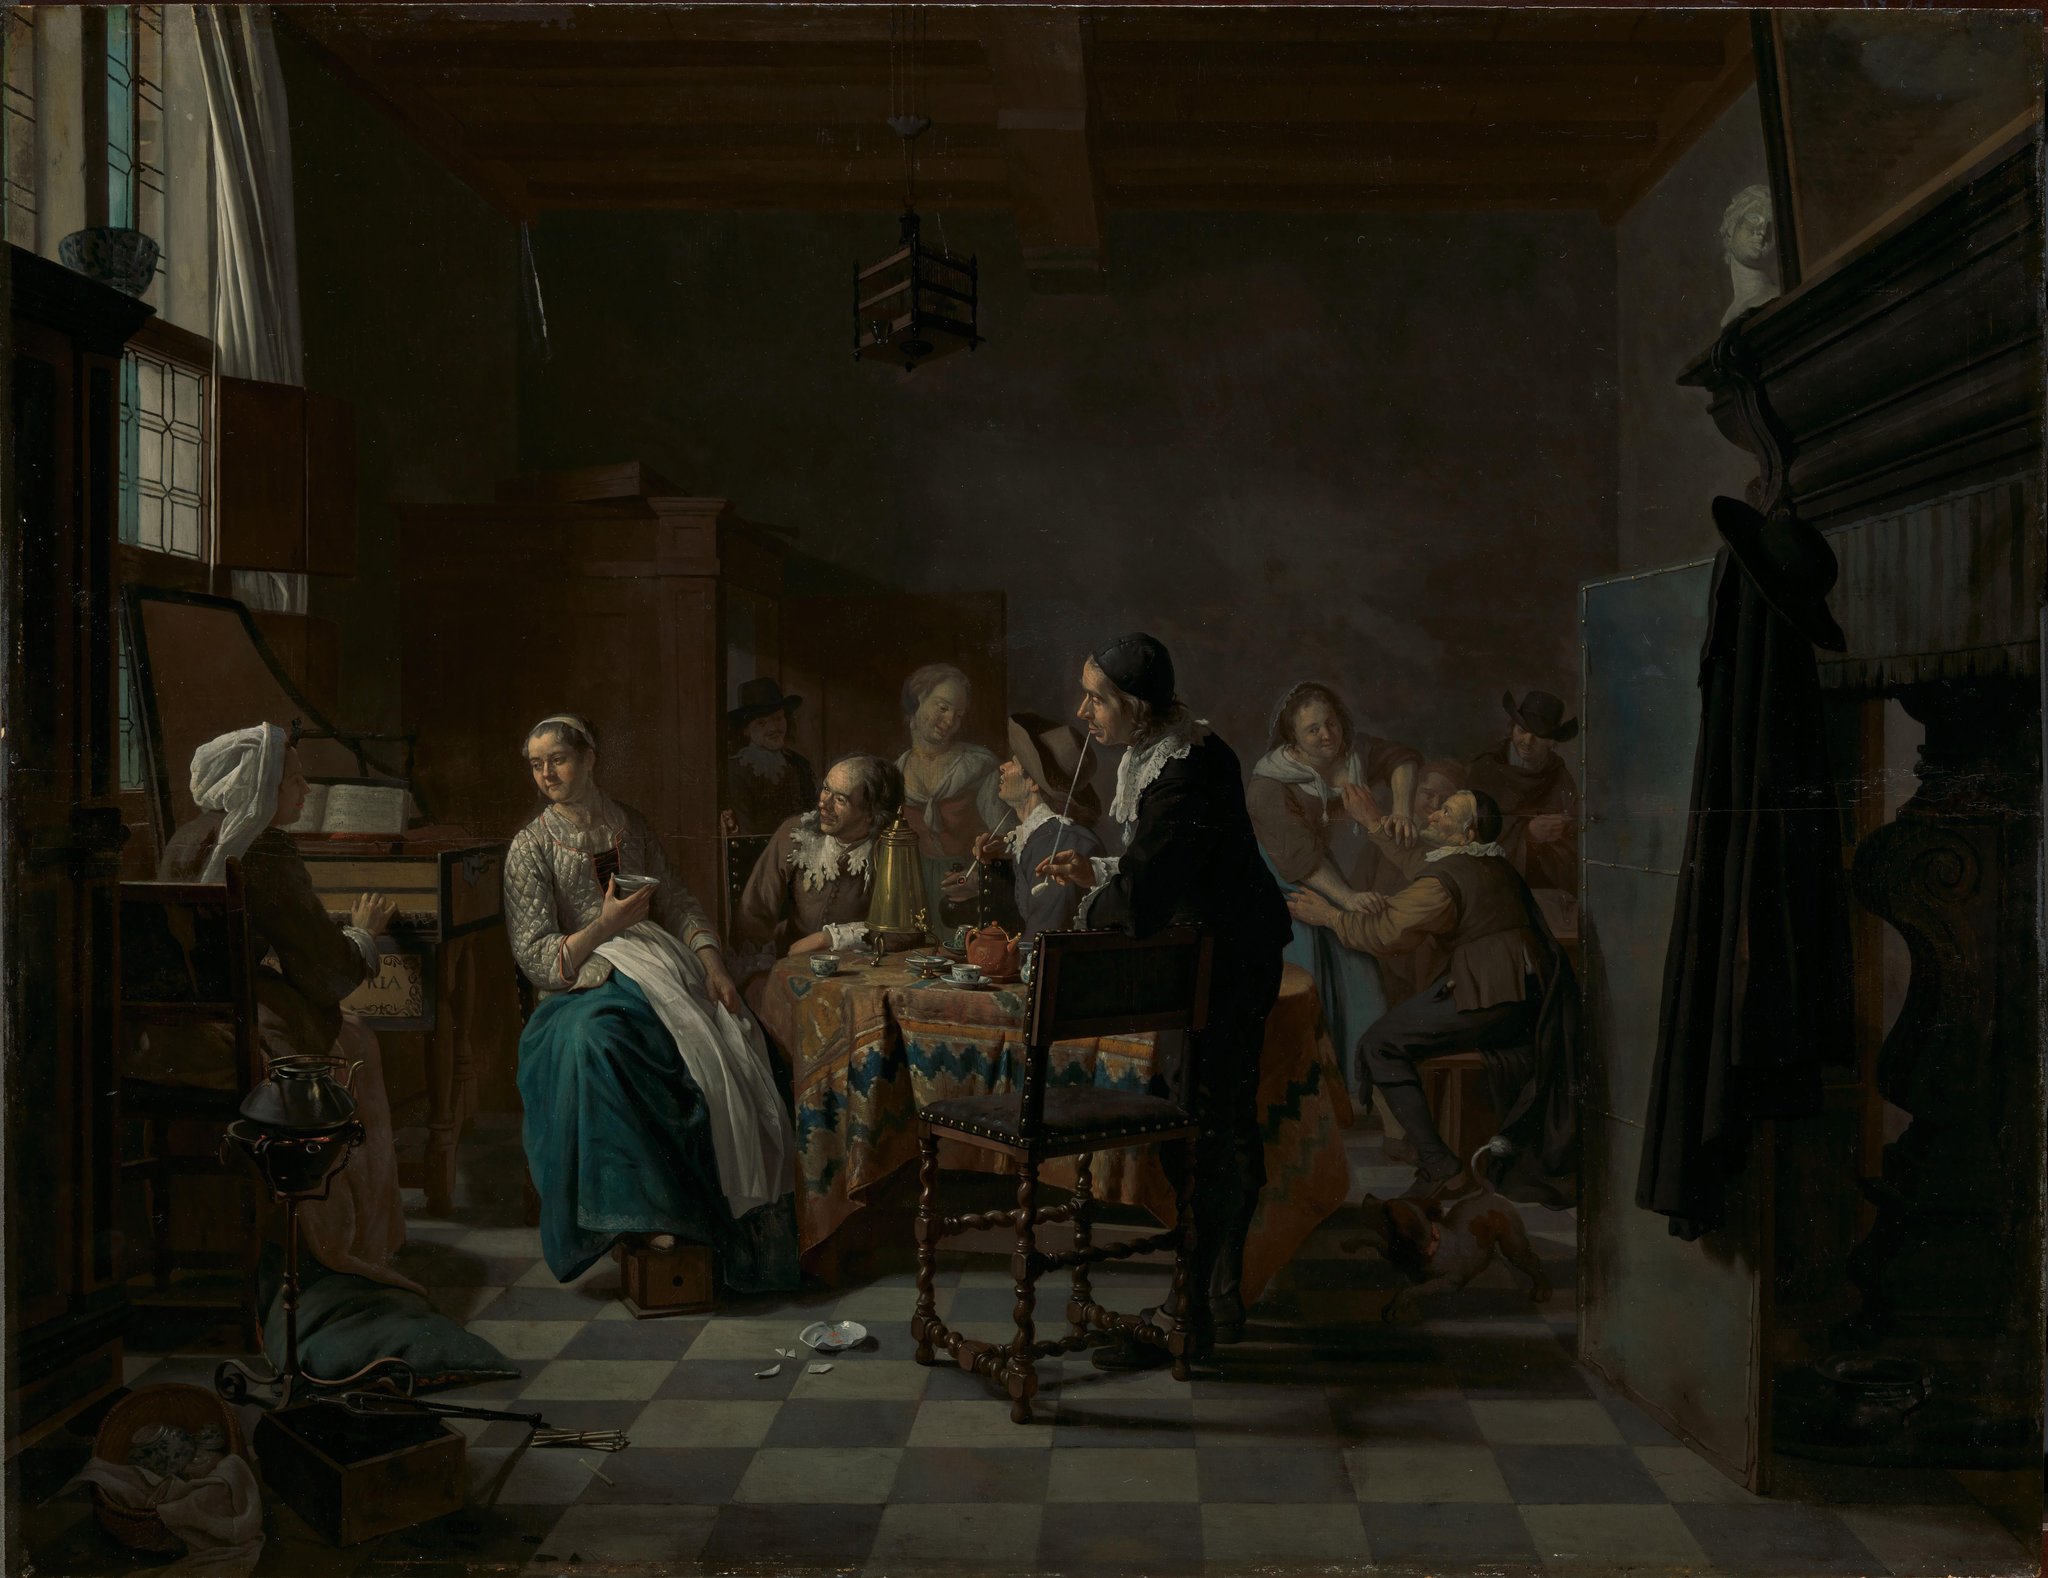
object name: painting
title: 'The New Song'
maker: jan josef horemans (ii)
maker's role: draughtsman, painter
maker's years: 1714-1790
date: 1740-1760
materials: oil, panel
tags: vocal music, singing, communal rooms, clavichord, harpsichord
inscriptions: signature: ‘JHoremans’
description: Interieur met een gezelschap rond de tafel, links een jonge vrouw die een lied uit liedboek speelt op een klavecimbel. Aan de tafel wordt thee gedronken, twee mannen roken pijpen. De vrouw links heeft een stoofje onder de voeten. Op de achtergrond vergrijpt een oude man zich aan een jonge vrouw. Rechts een scherm voor de schoorsteenmantel waaraan een jas en een hoed hangen. Aan het plafond hangt een vogelkooi.